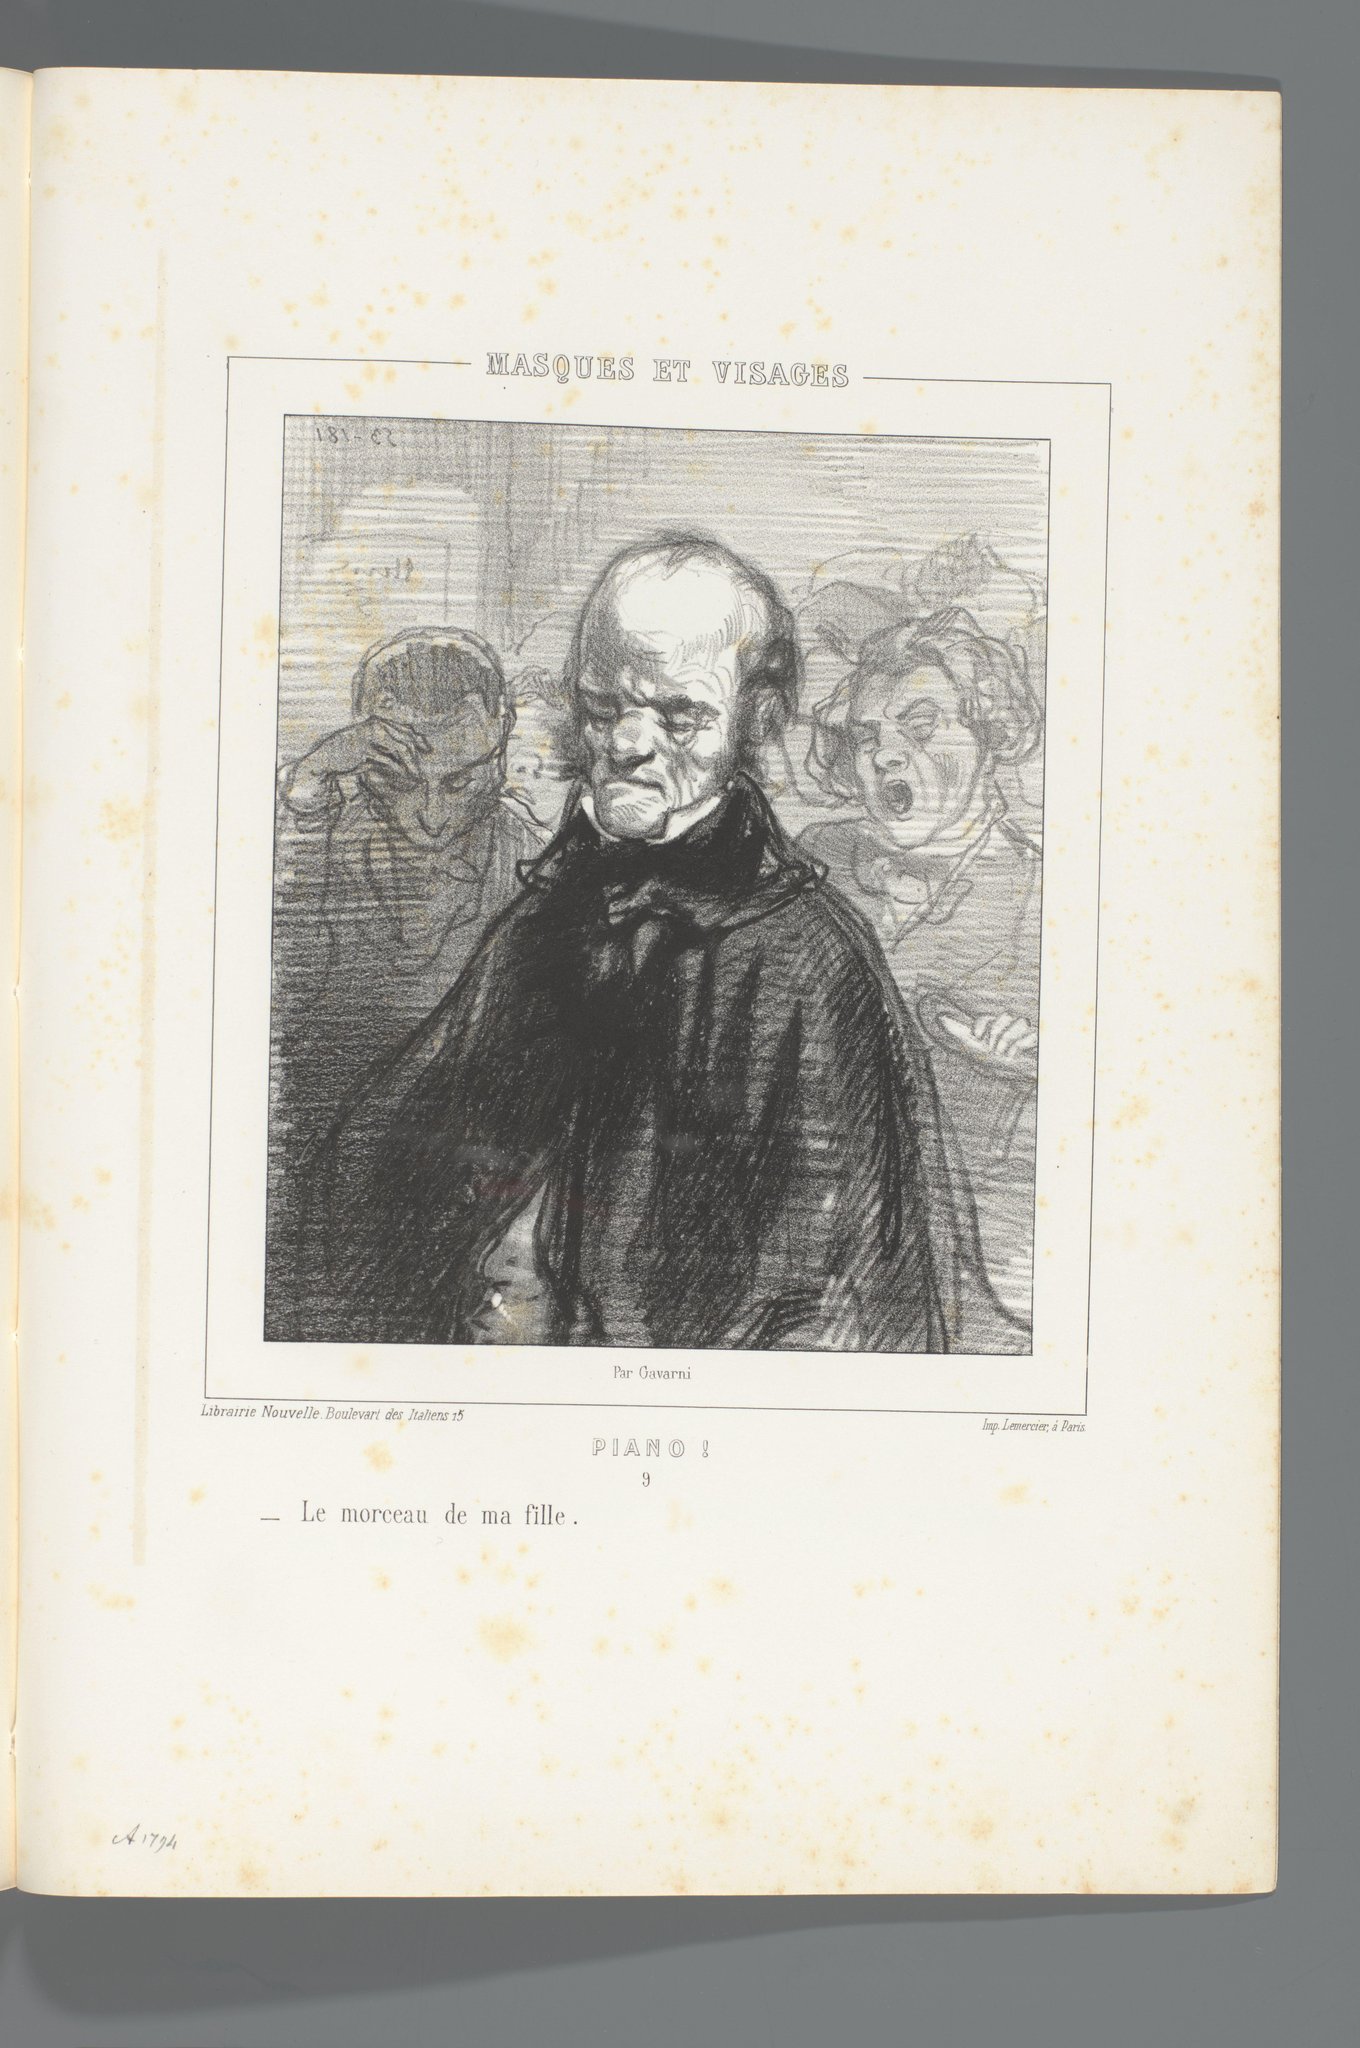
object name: print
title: Masques et Visages. Piano!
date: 1853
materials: paper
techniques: lithograph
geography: paris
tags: father with daughter(s) (father-love), listening to music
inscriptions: collector's mark: Lugt 964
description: Deze prent maakt deel uit van een album.